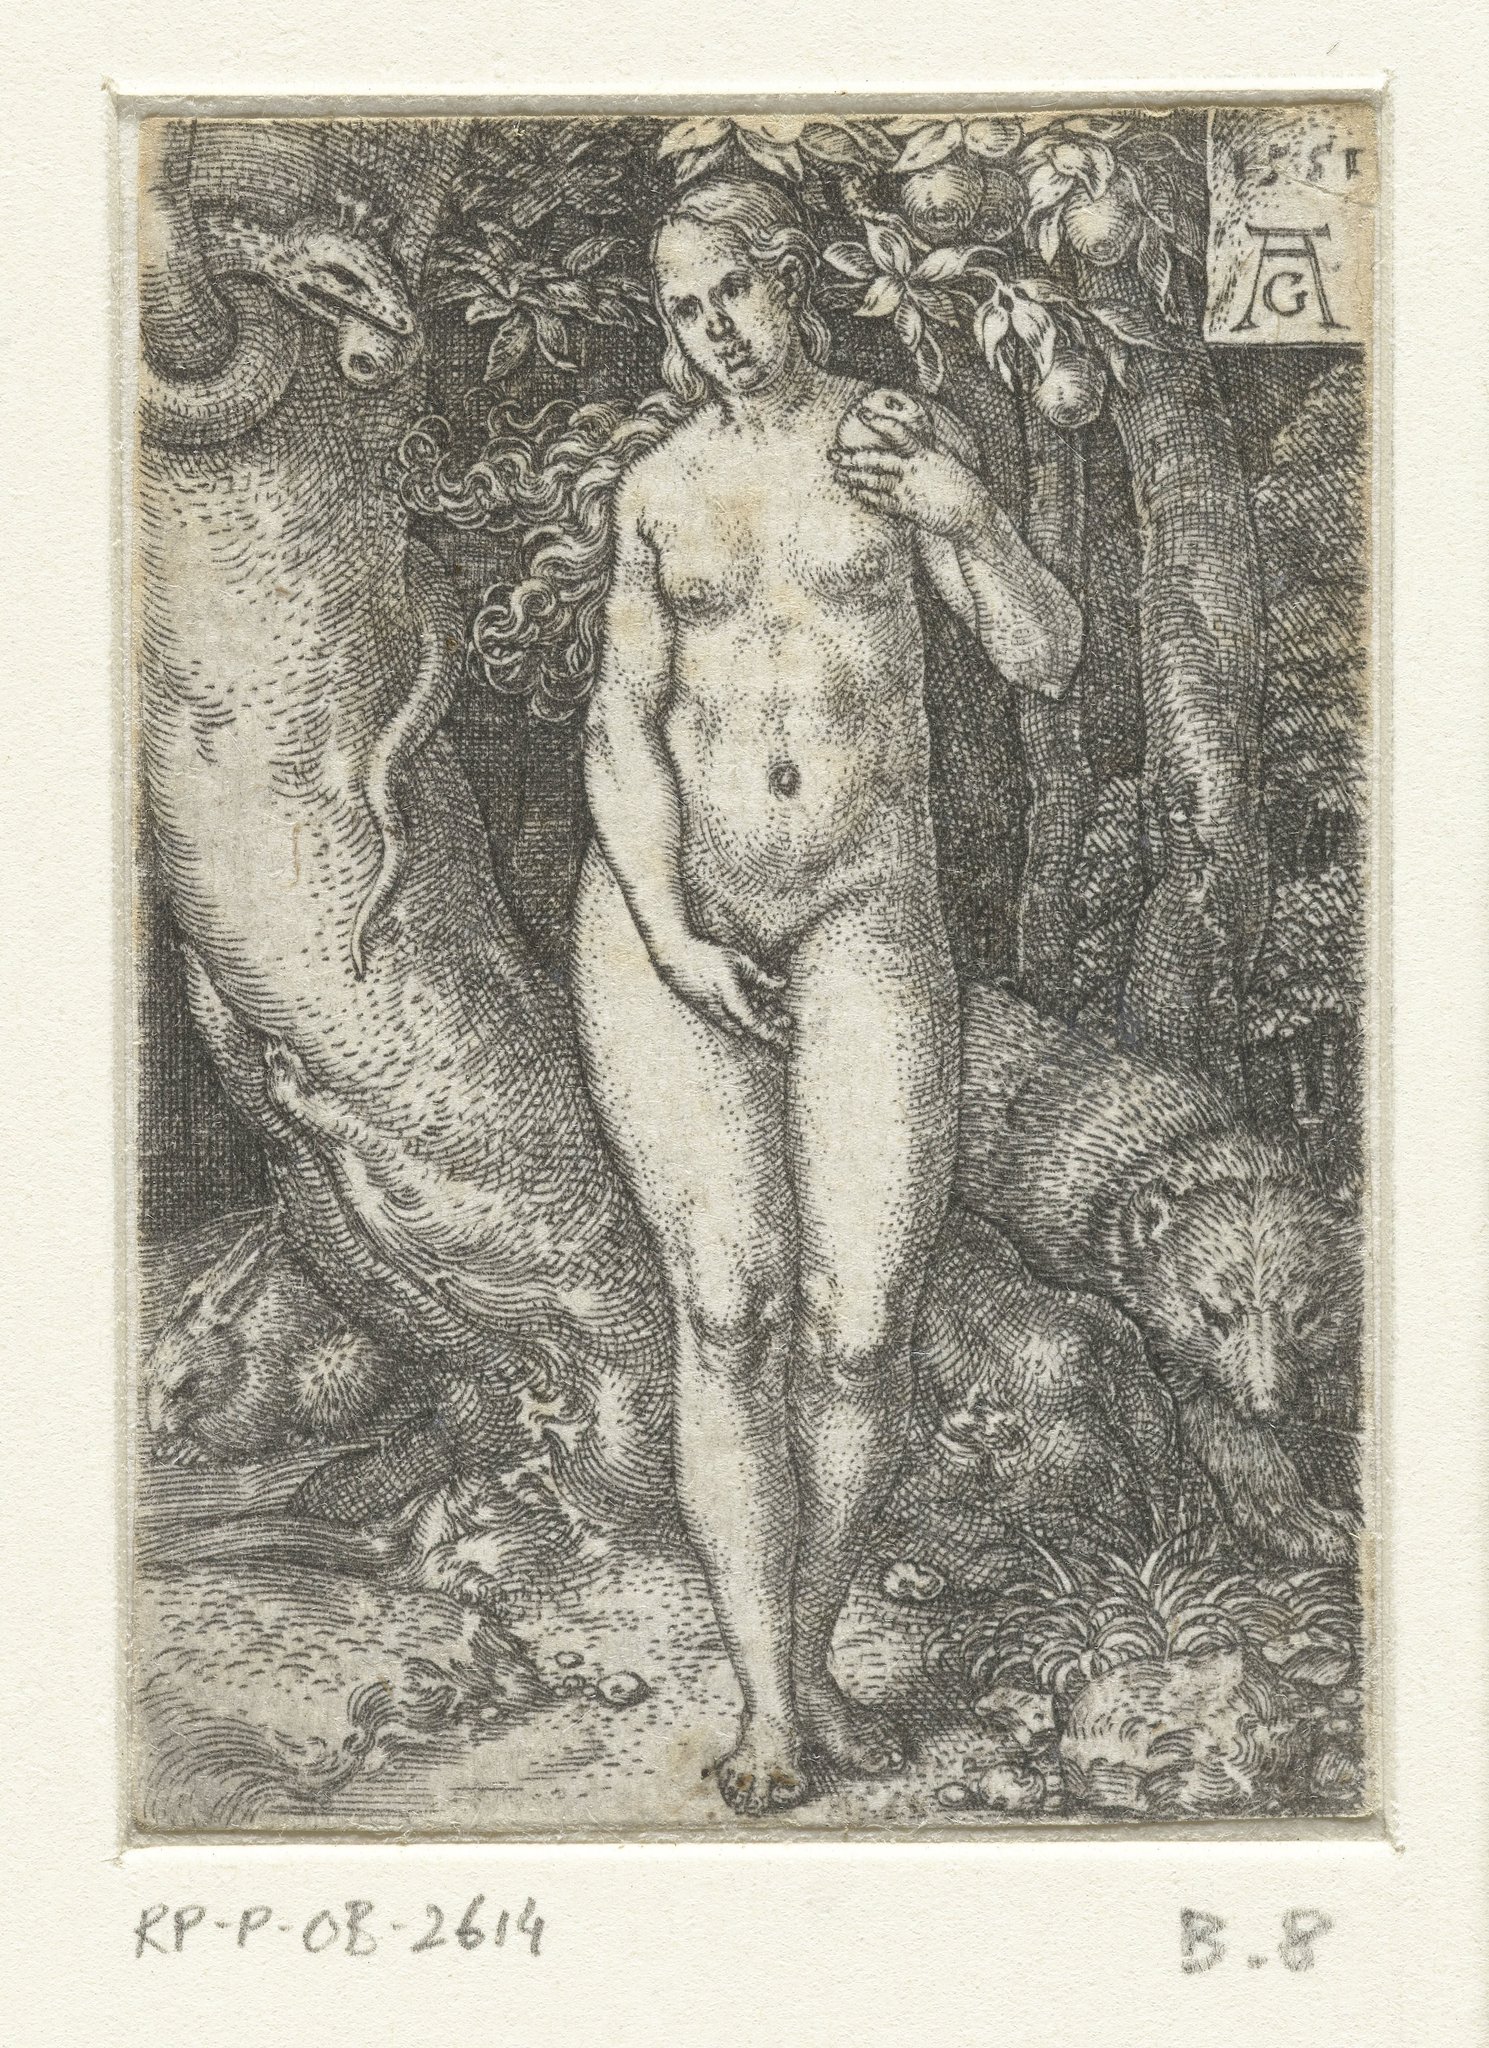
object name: print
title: Eva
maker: heinrich aldegrever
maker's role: draughtsman, print maker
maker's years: 1502-1561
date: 1551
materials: paper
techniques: engraving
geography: germany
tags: eve takes the fruit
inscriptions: date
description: Eva, van voren gezien, naakt en staand met de verboden vrucht in haar hand. Rechts van haar de slag met een vrucht in de boom, achter de boom een haas en een beer. Vormt samen met een prent met Adam een voorstelling van de zondeval.